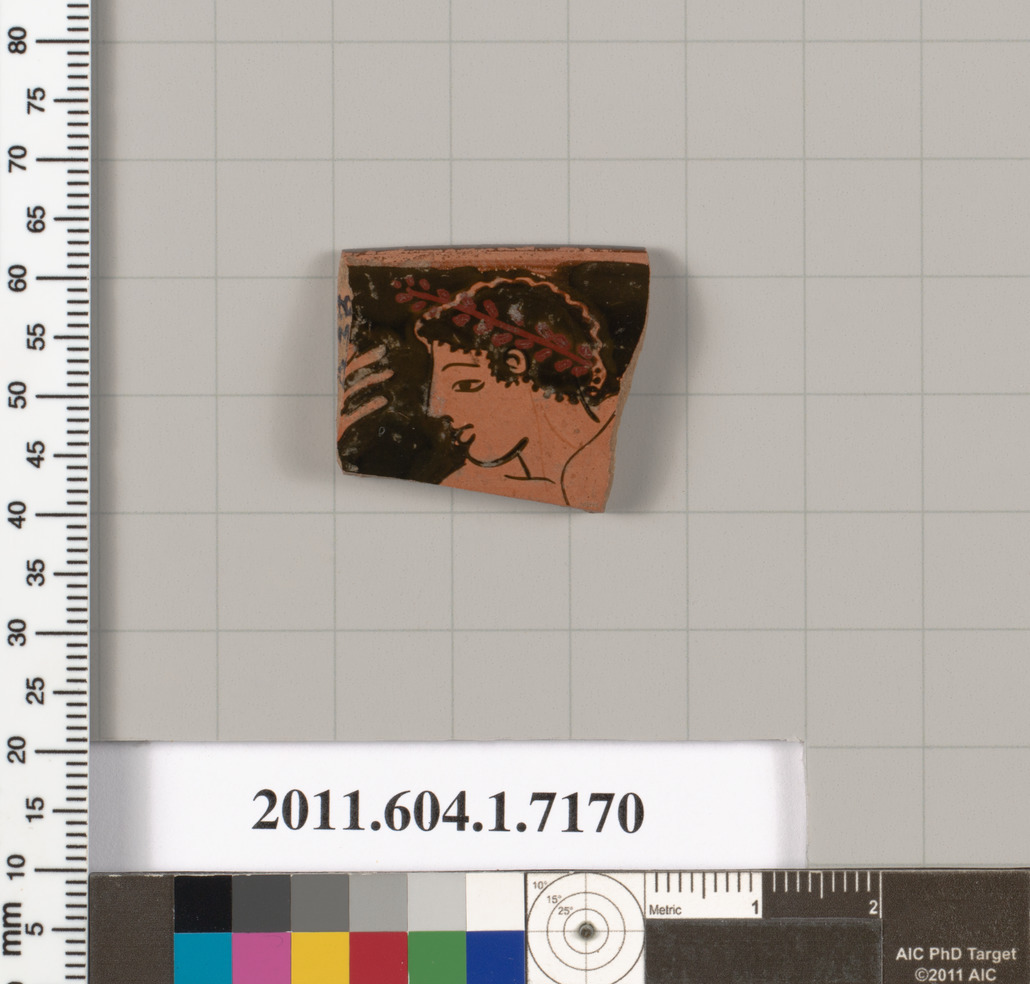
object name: kylix fragment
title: Terracotta rim fragment of a kylix (drinking cup)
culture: greek, attic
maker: makron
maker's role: artist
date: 500-480 BCE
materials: terracotta